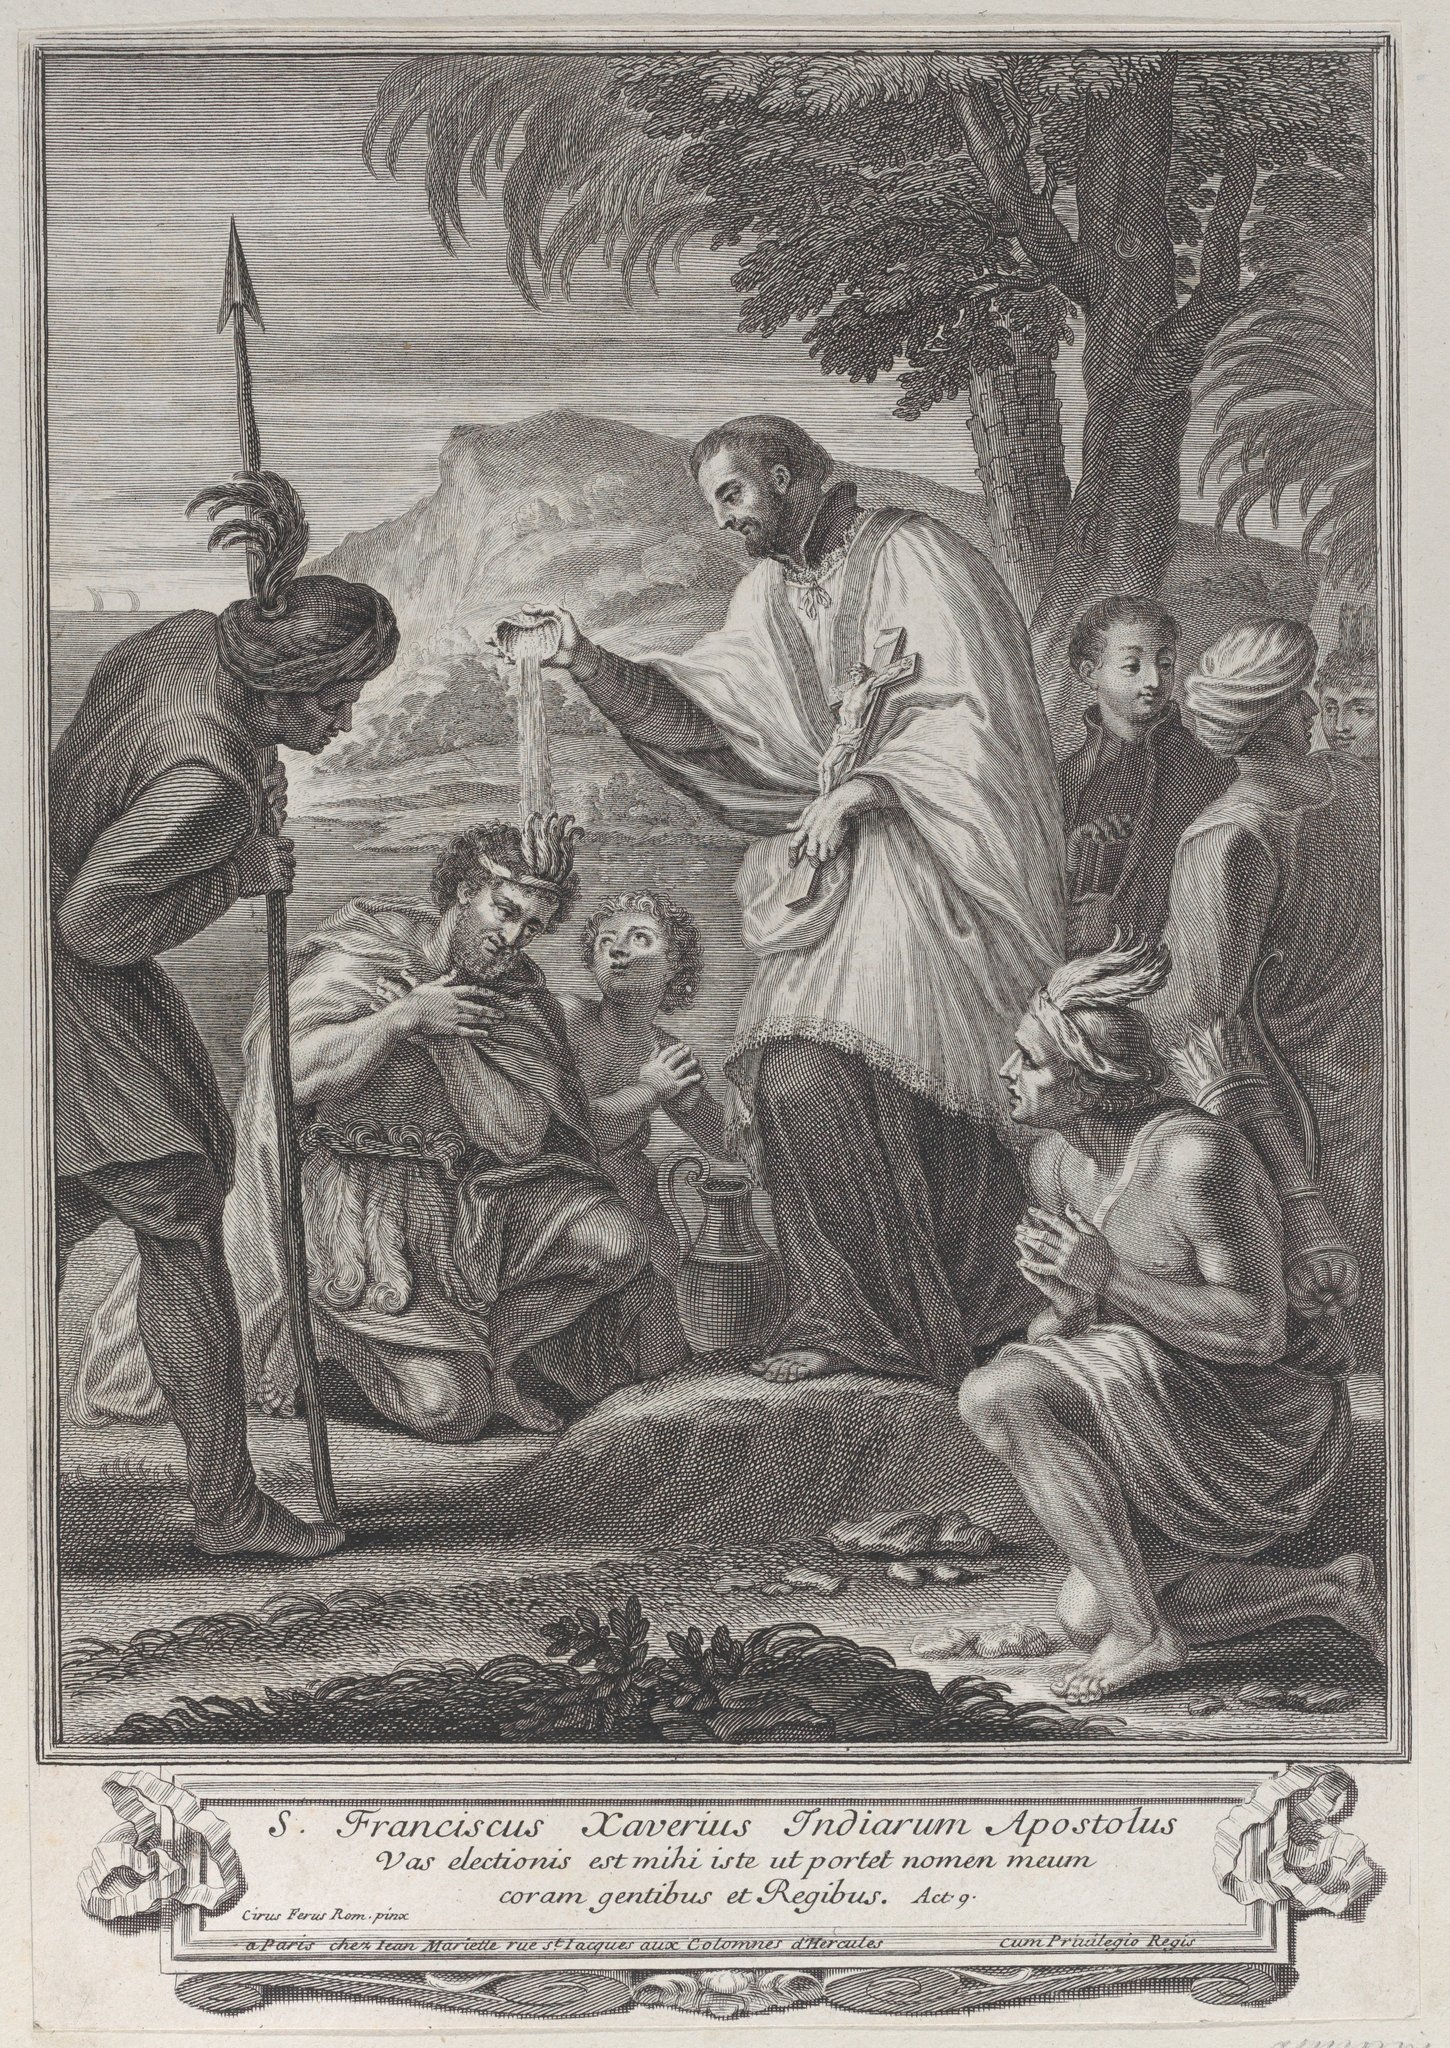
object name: print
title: Saint Francis Xavier baptizing the Indians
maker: Anonymous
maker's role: artist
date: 1714-1774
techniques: engraving